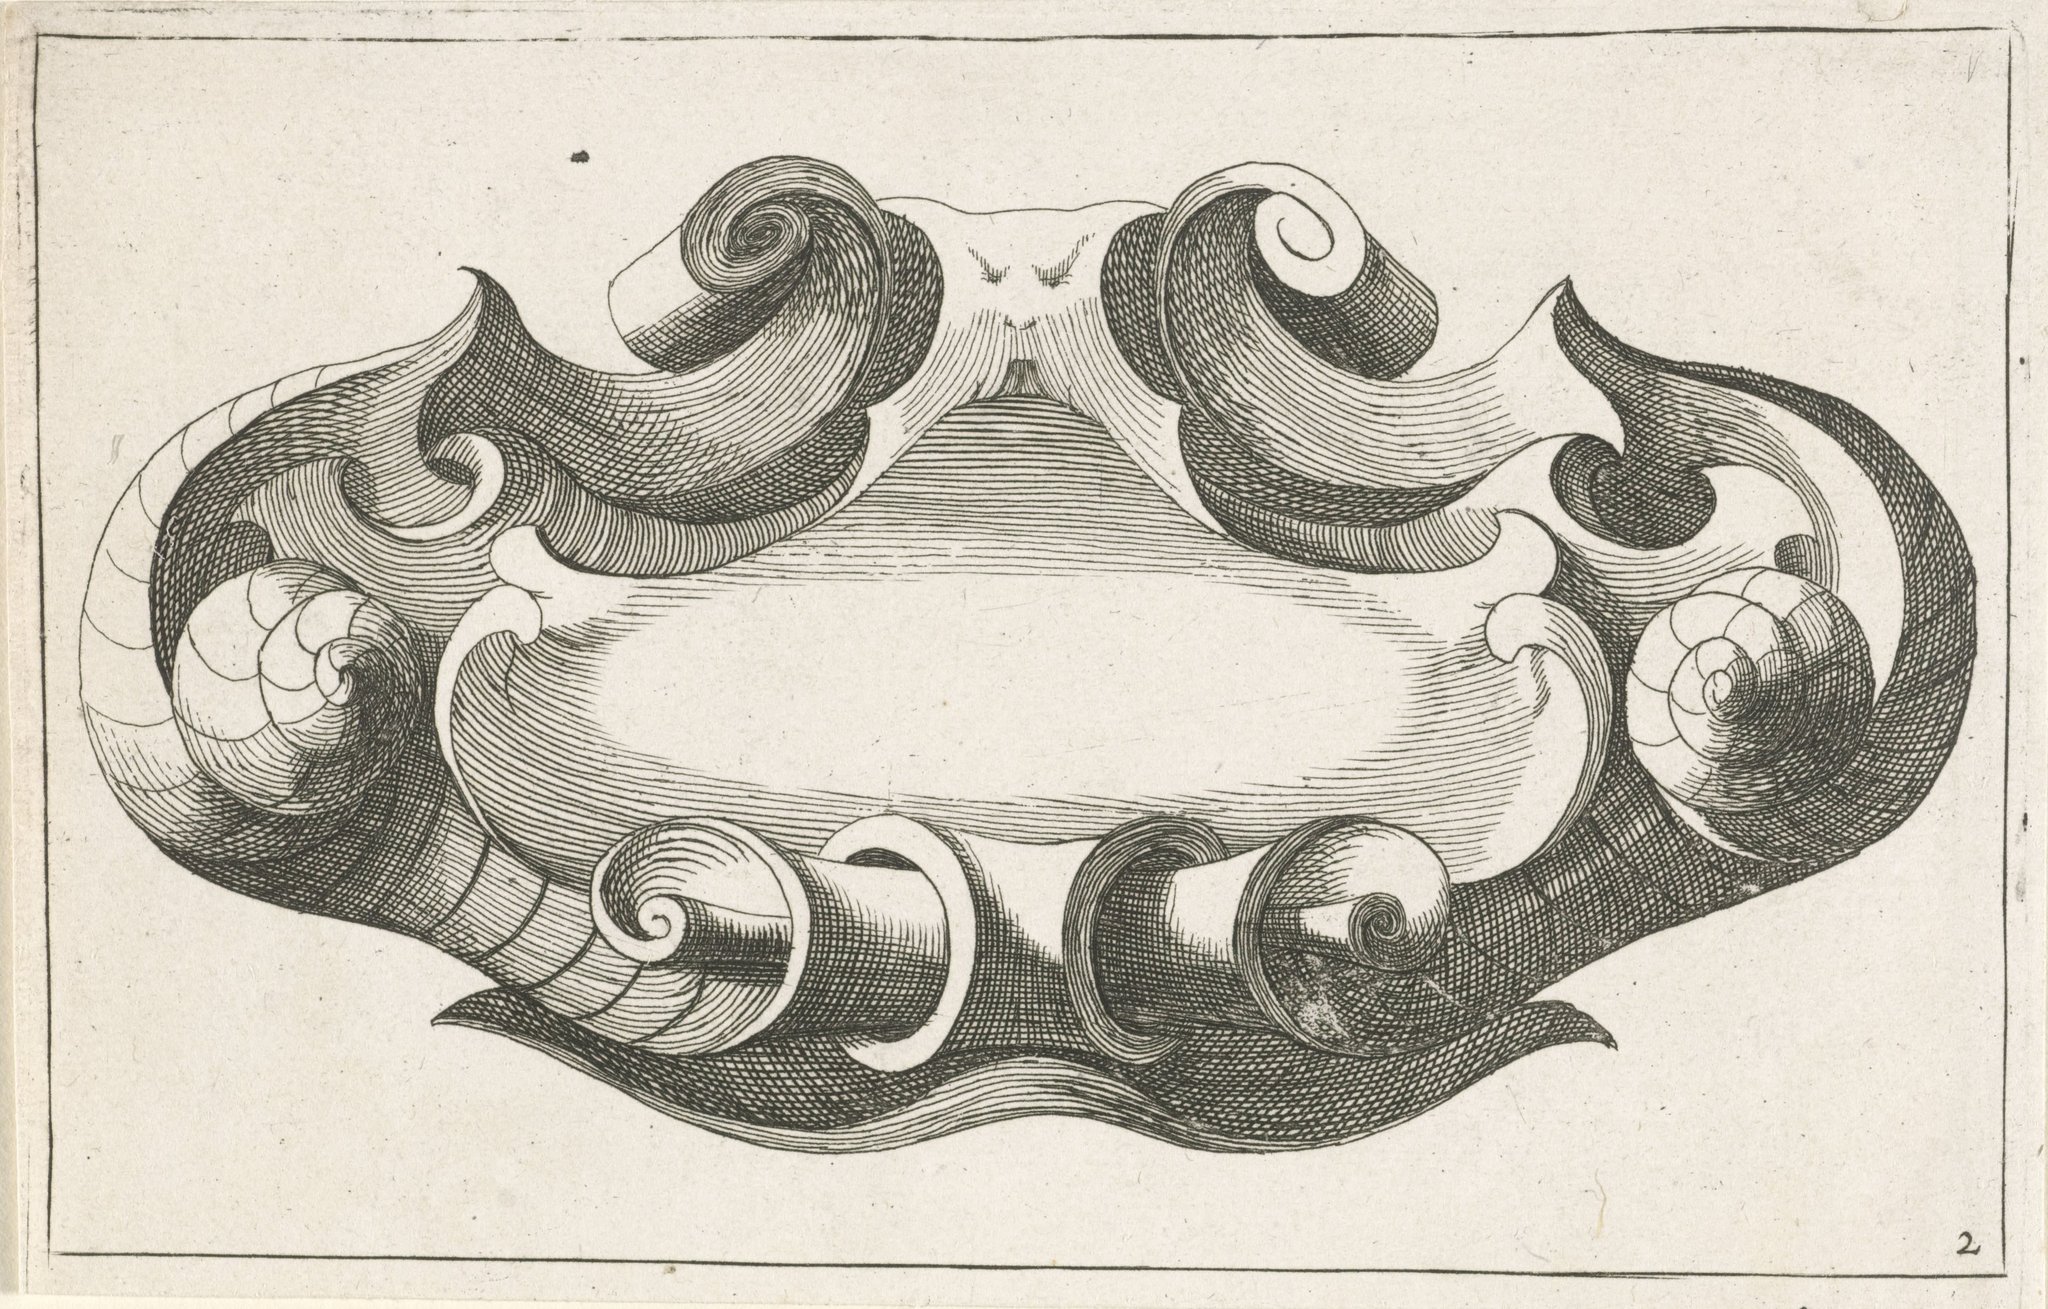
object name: print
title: Differents Conpartimens et Chapiteaux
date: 1657-1685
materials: paper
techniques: engraving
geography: paris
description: Uit serie van 22 of 29 bladen met cartouches in Italiaanse kwabstijl, vierde editie.